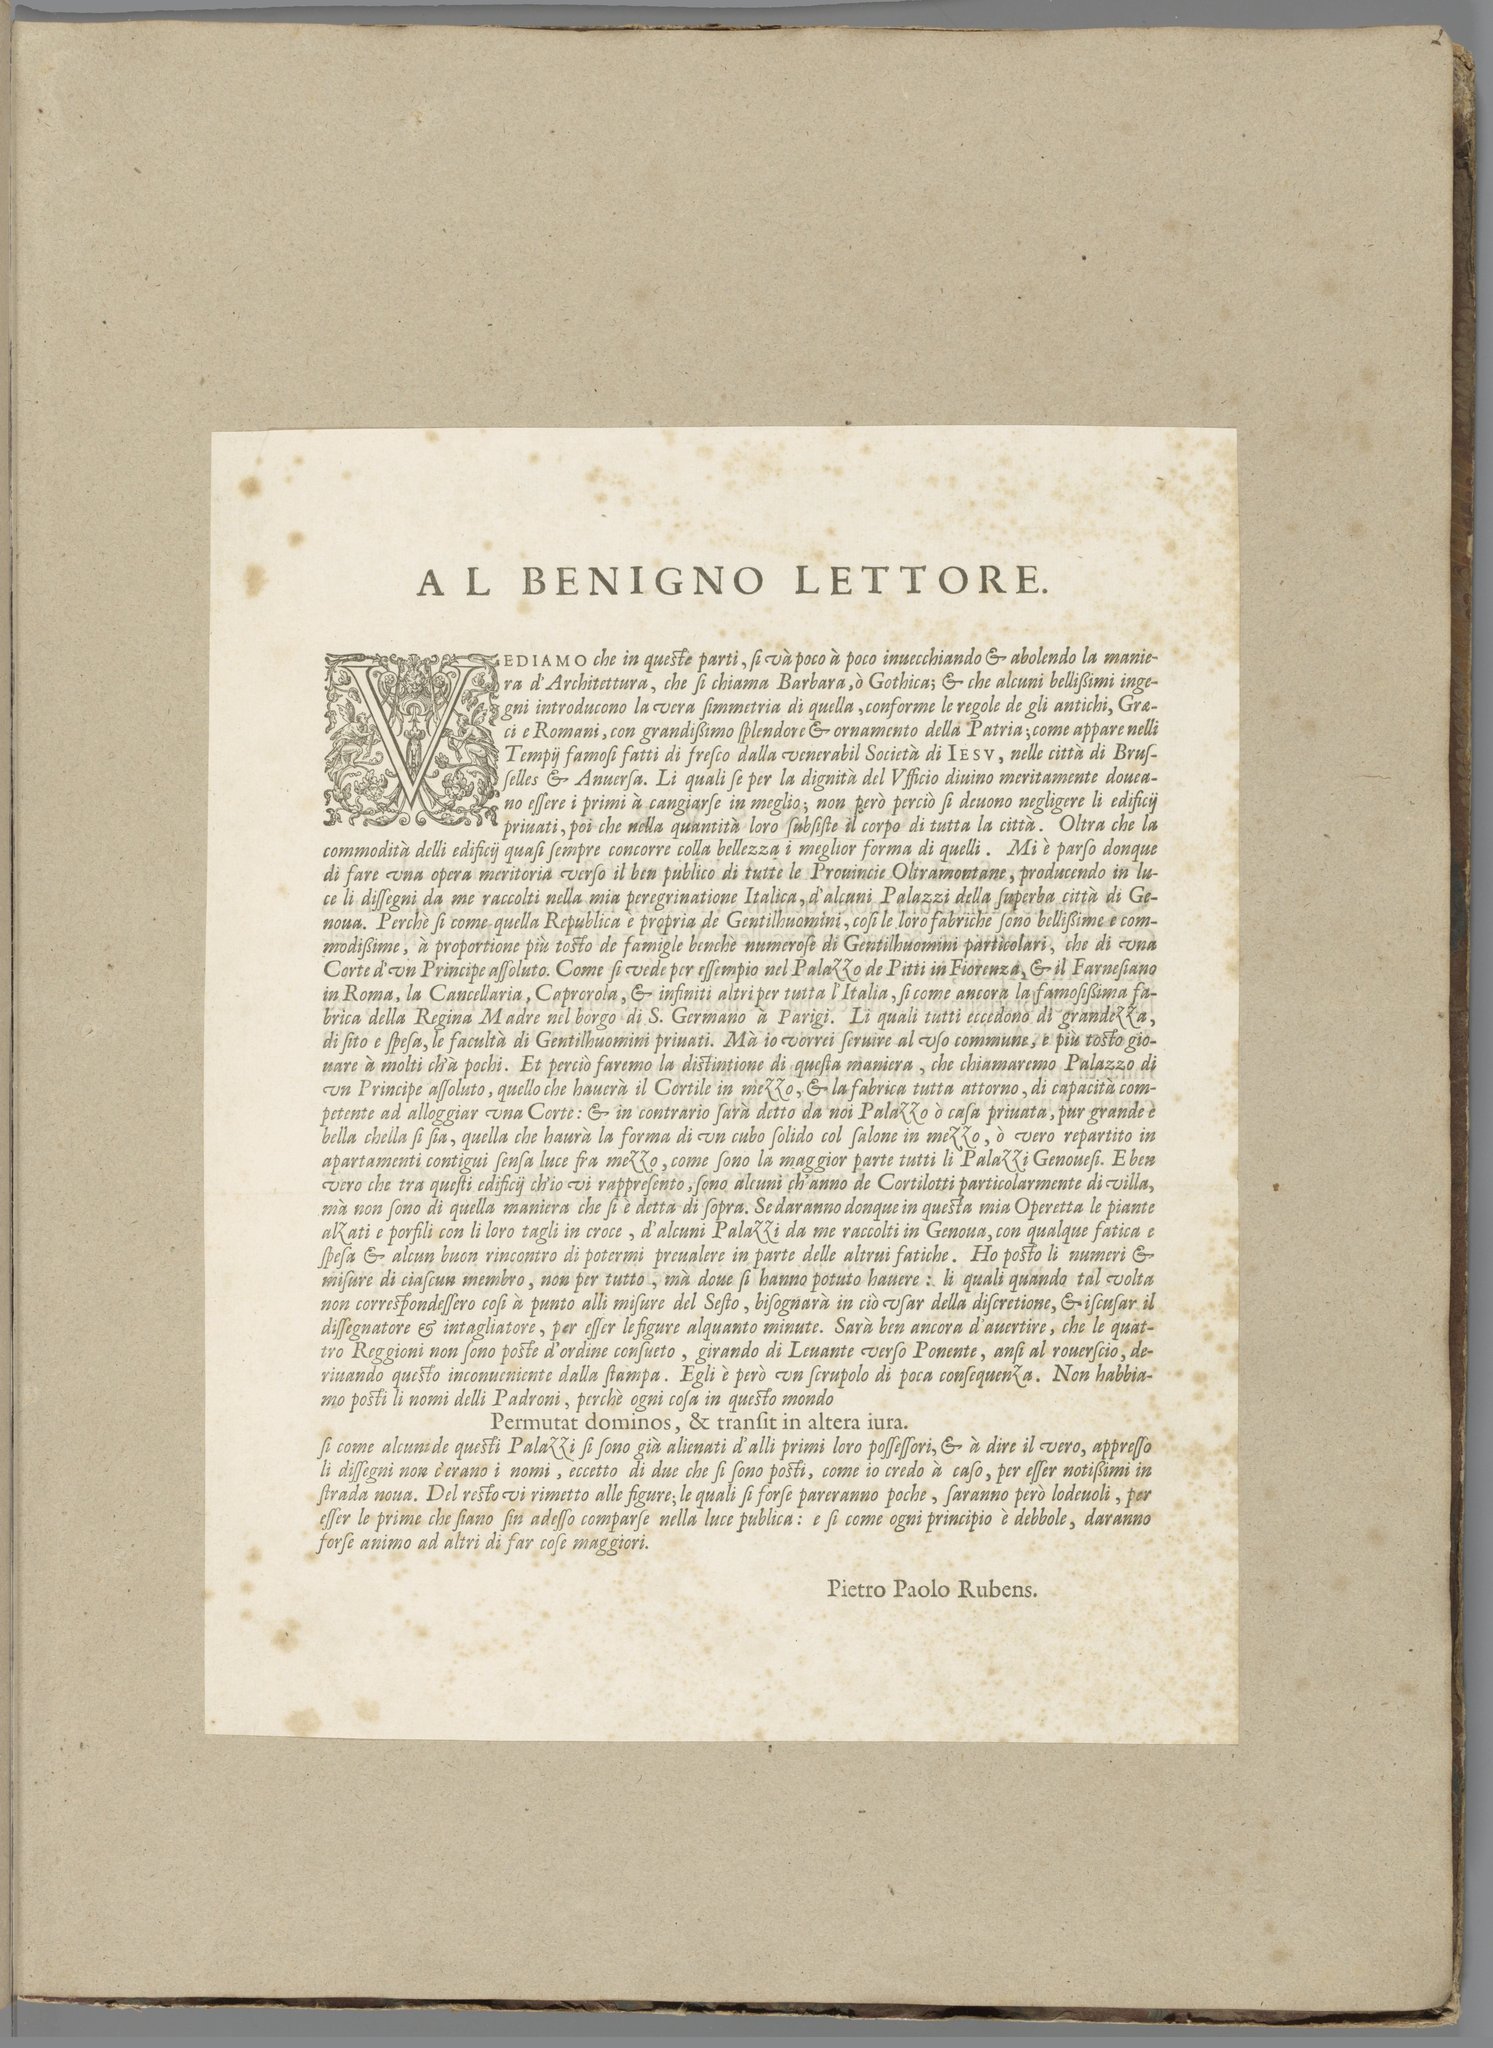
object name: album leaf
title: Opdracht aan de lezer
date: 1622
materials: paper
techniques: letterpress printing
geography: antwerp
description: Recto 'Al benigno lectore', een opdracht aan de lezer door Rubens. Verso 'Censura' door Laurens Beyerlinck. Dit blad maakt deel uit van een album.